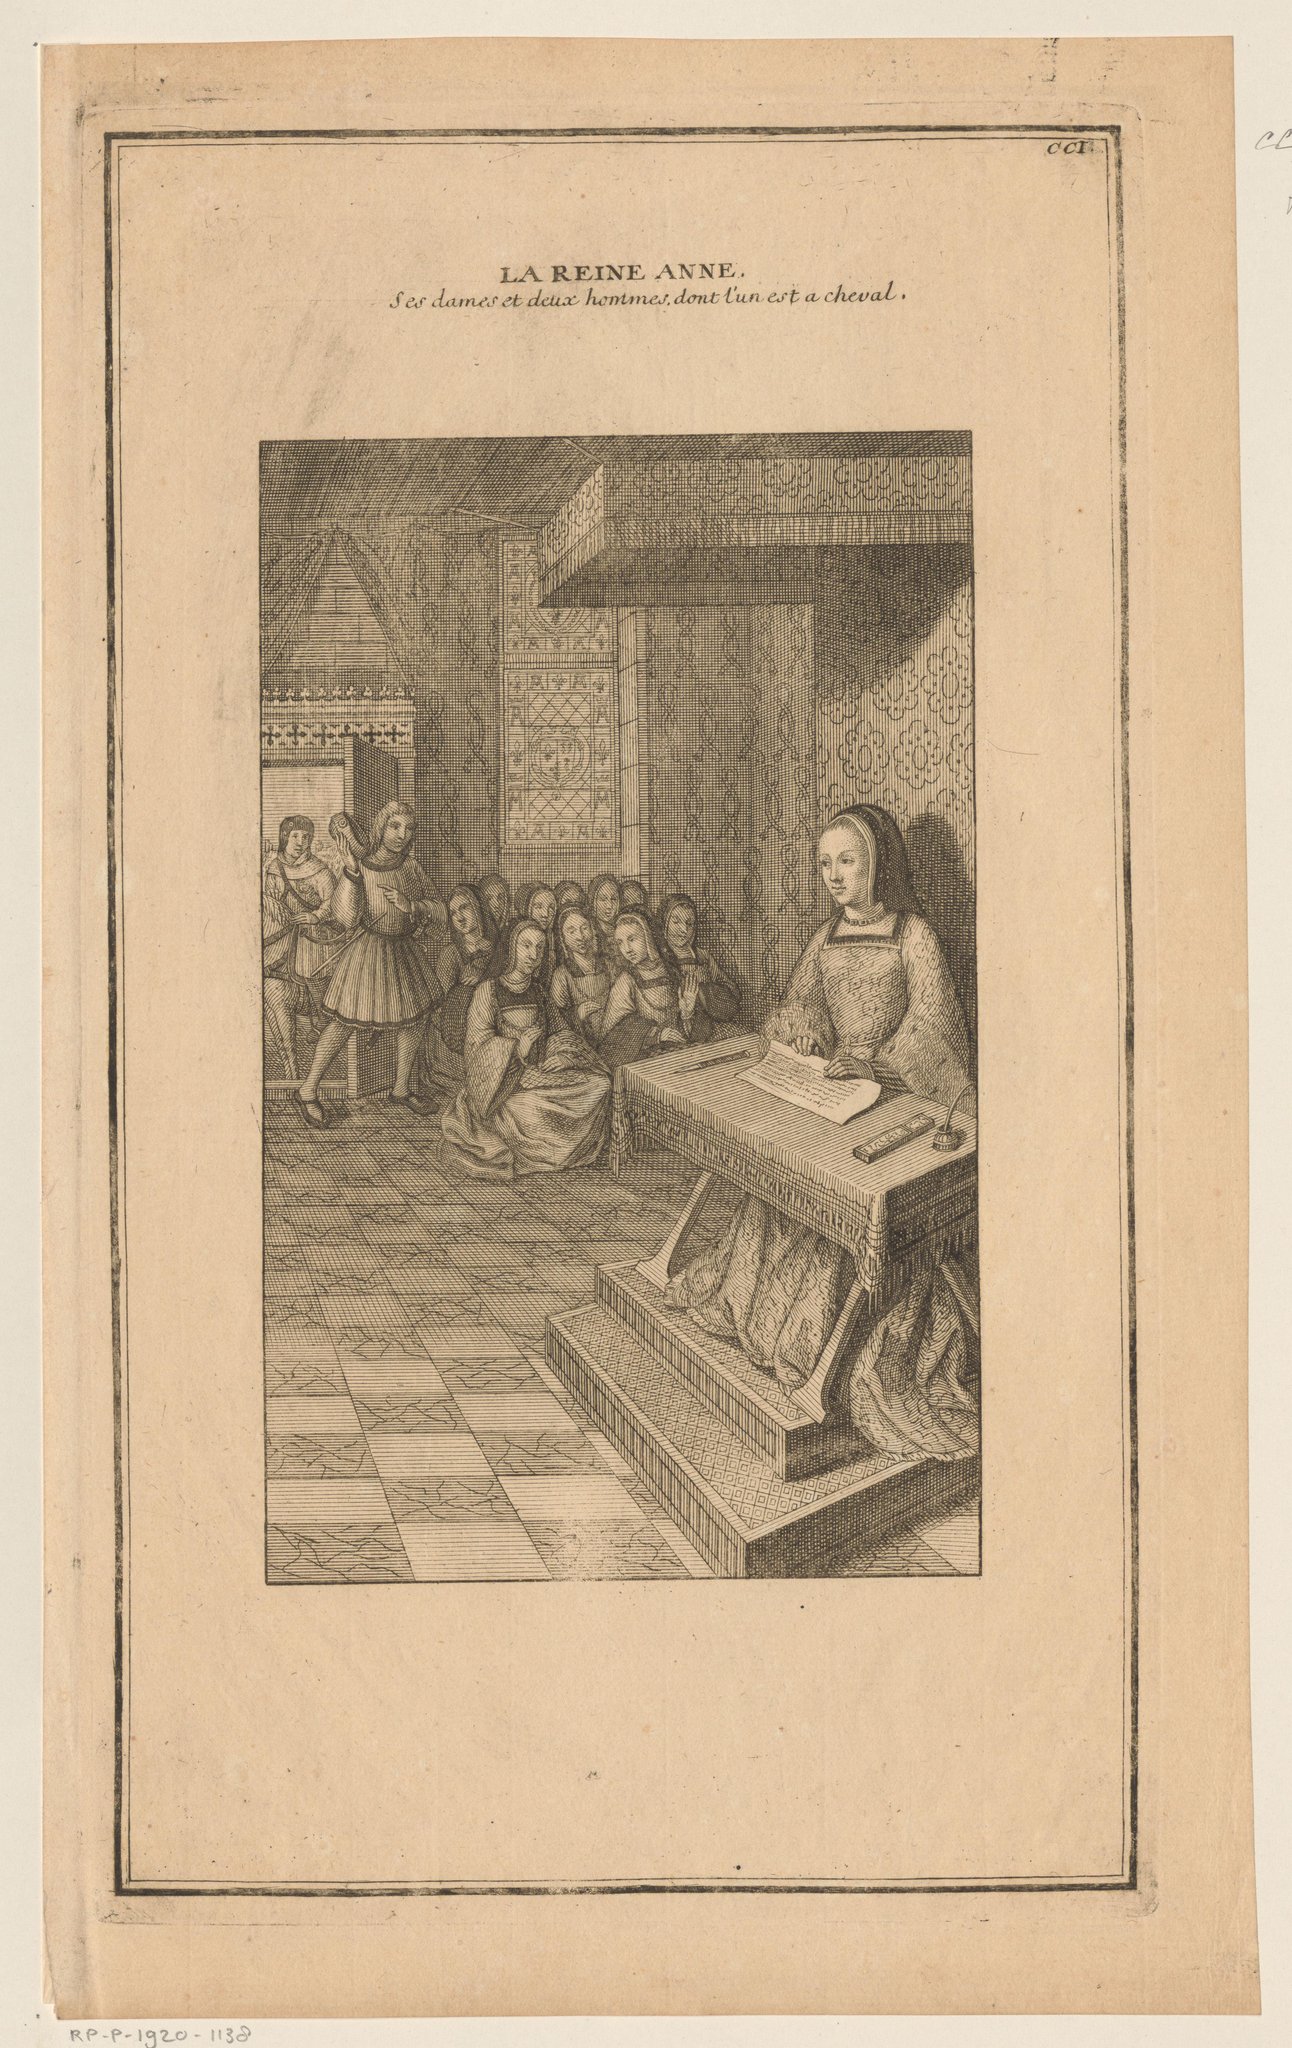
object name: book illustration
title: Portret van Anna van Bretagne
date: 1750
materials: paper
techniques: etching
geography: london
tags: writing-table, writing-desk, historical persons - bb - woman, dignitary at court - bb - female dignitary: lady-in-waiting, letter, envelope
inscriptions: collector's mark: Lugt 2228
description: Prent uit: Montfaucon, Bernard de. A collection of regal and ecclesiastical antiquities of France (...). Londen: William Innys, John en Paul Knapton, R. Manby en Henry Shute Cox, 1750, dl. 2. Prent voor het eerst, met andere nummering, verschenen in: Montfaucon, Bernard de. Les monumens de la Monarchie Françoise (...). Parijs: Julien-Michel Gandouin en Pierre-François Giffart, 1729-1733.